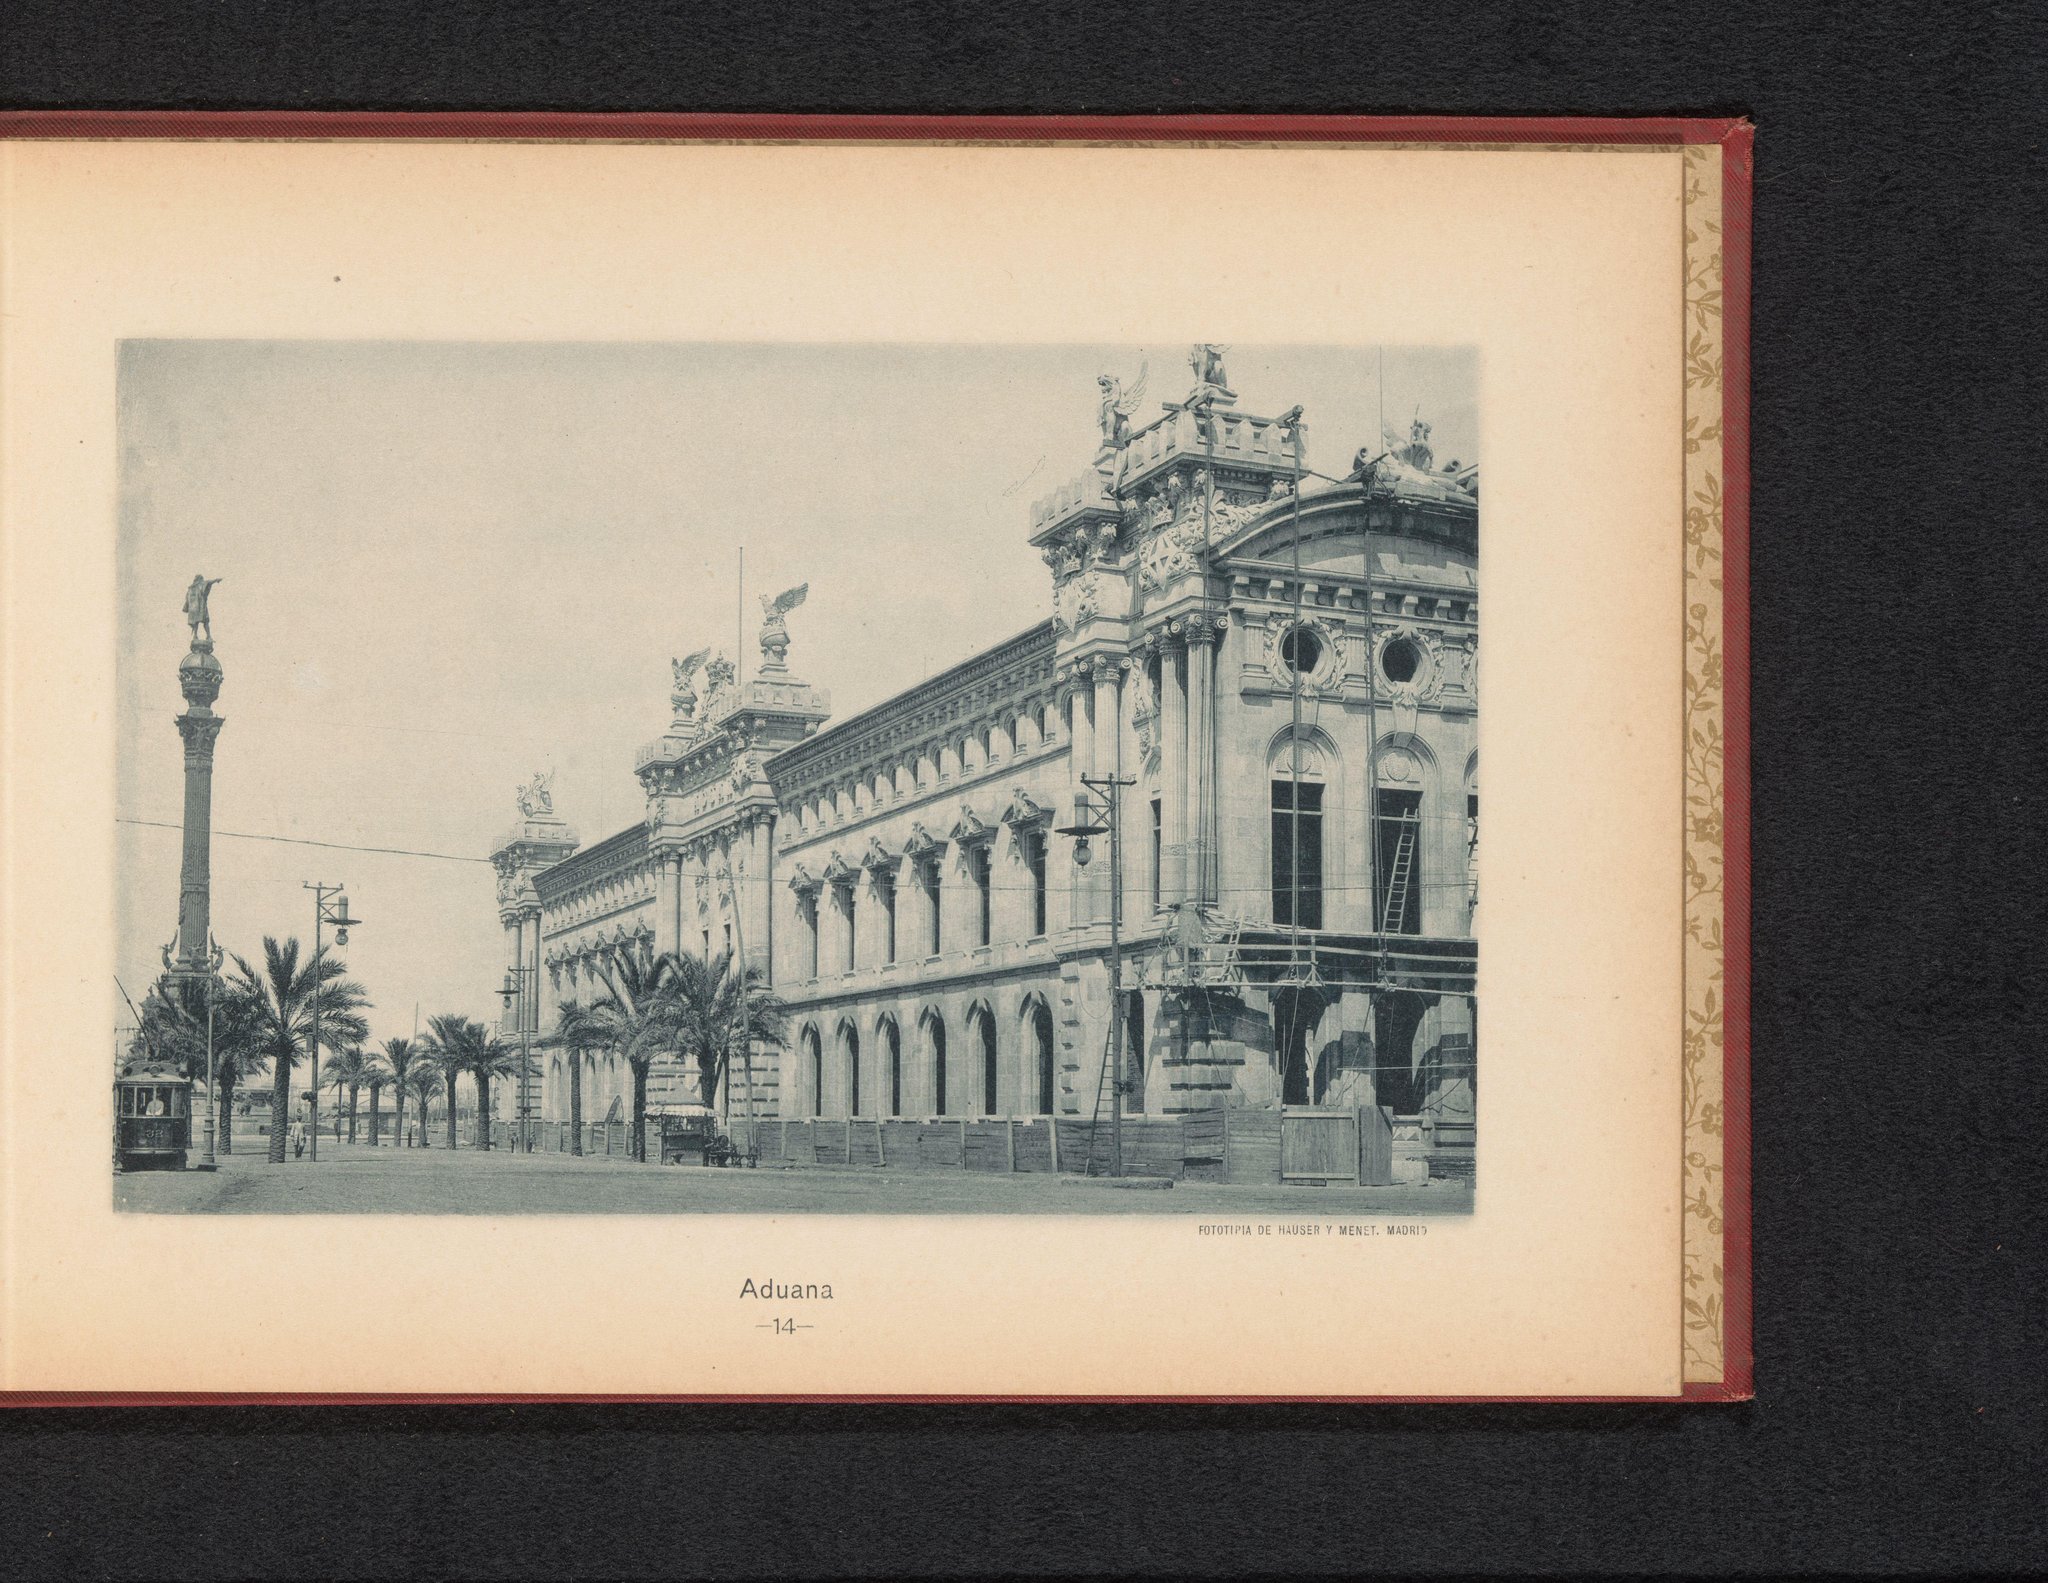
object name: page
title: Aduana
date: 1880-1890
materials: paper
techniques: photograph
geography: barcelona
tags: customs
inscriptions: number: ‘-14-’